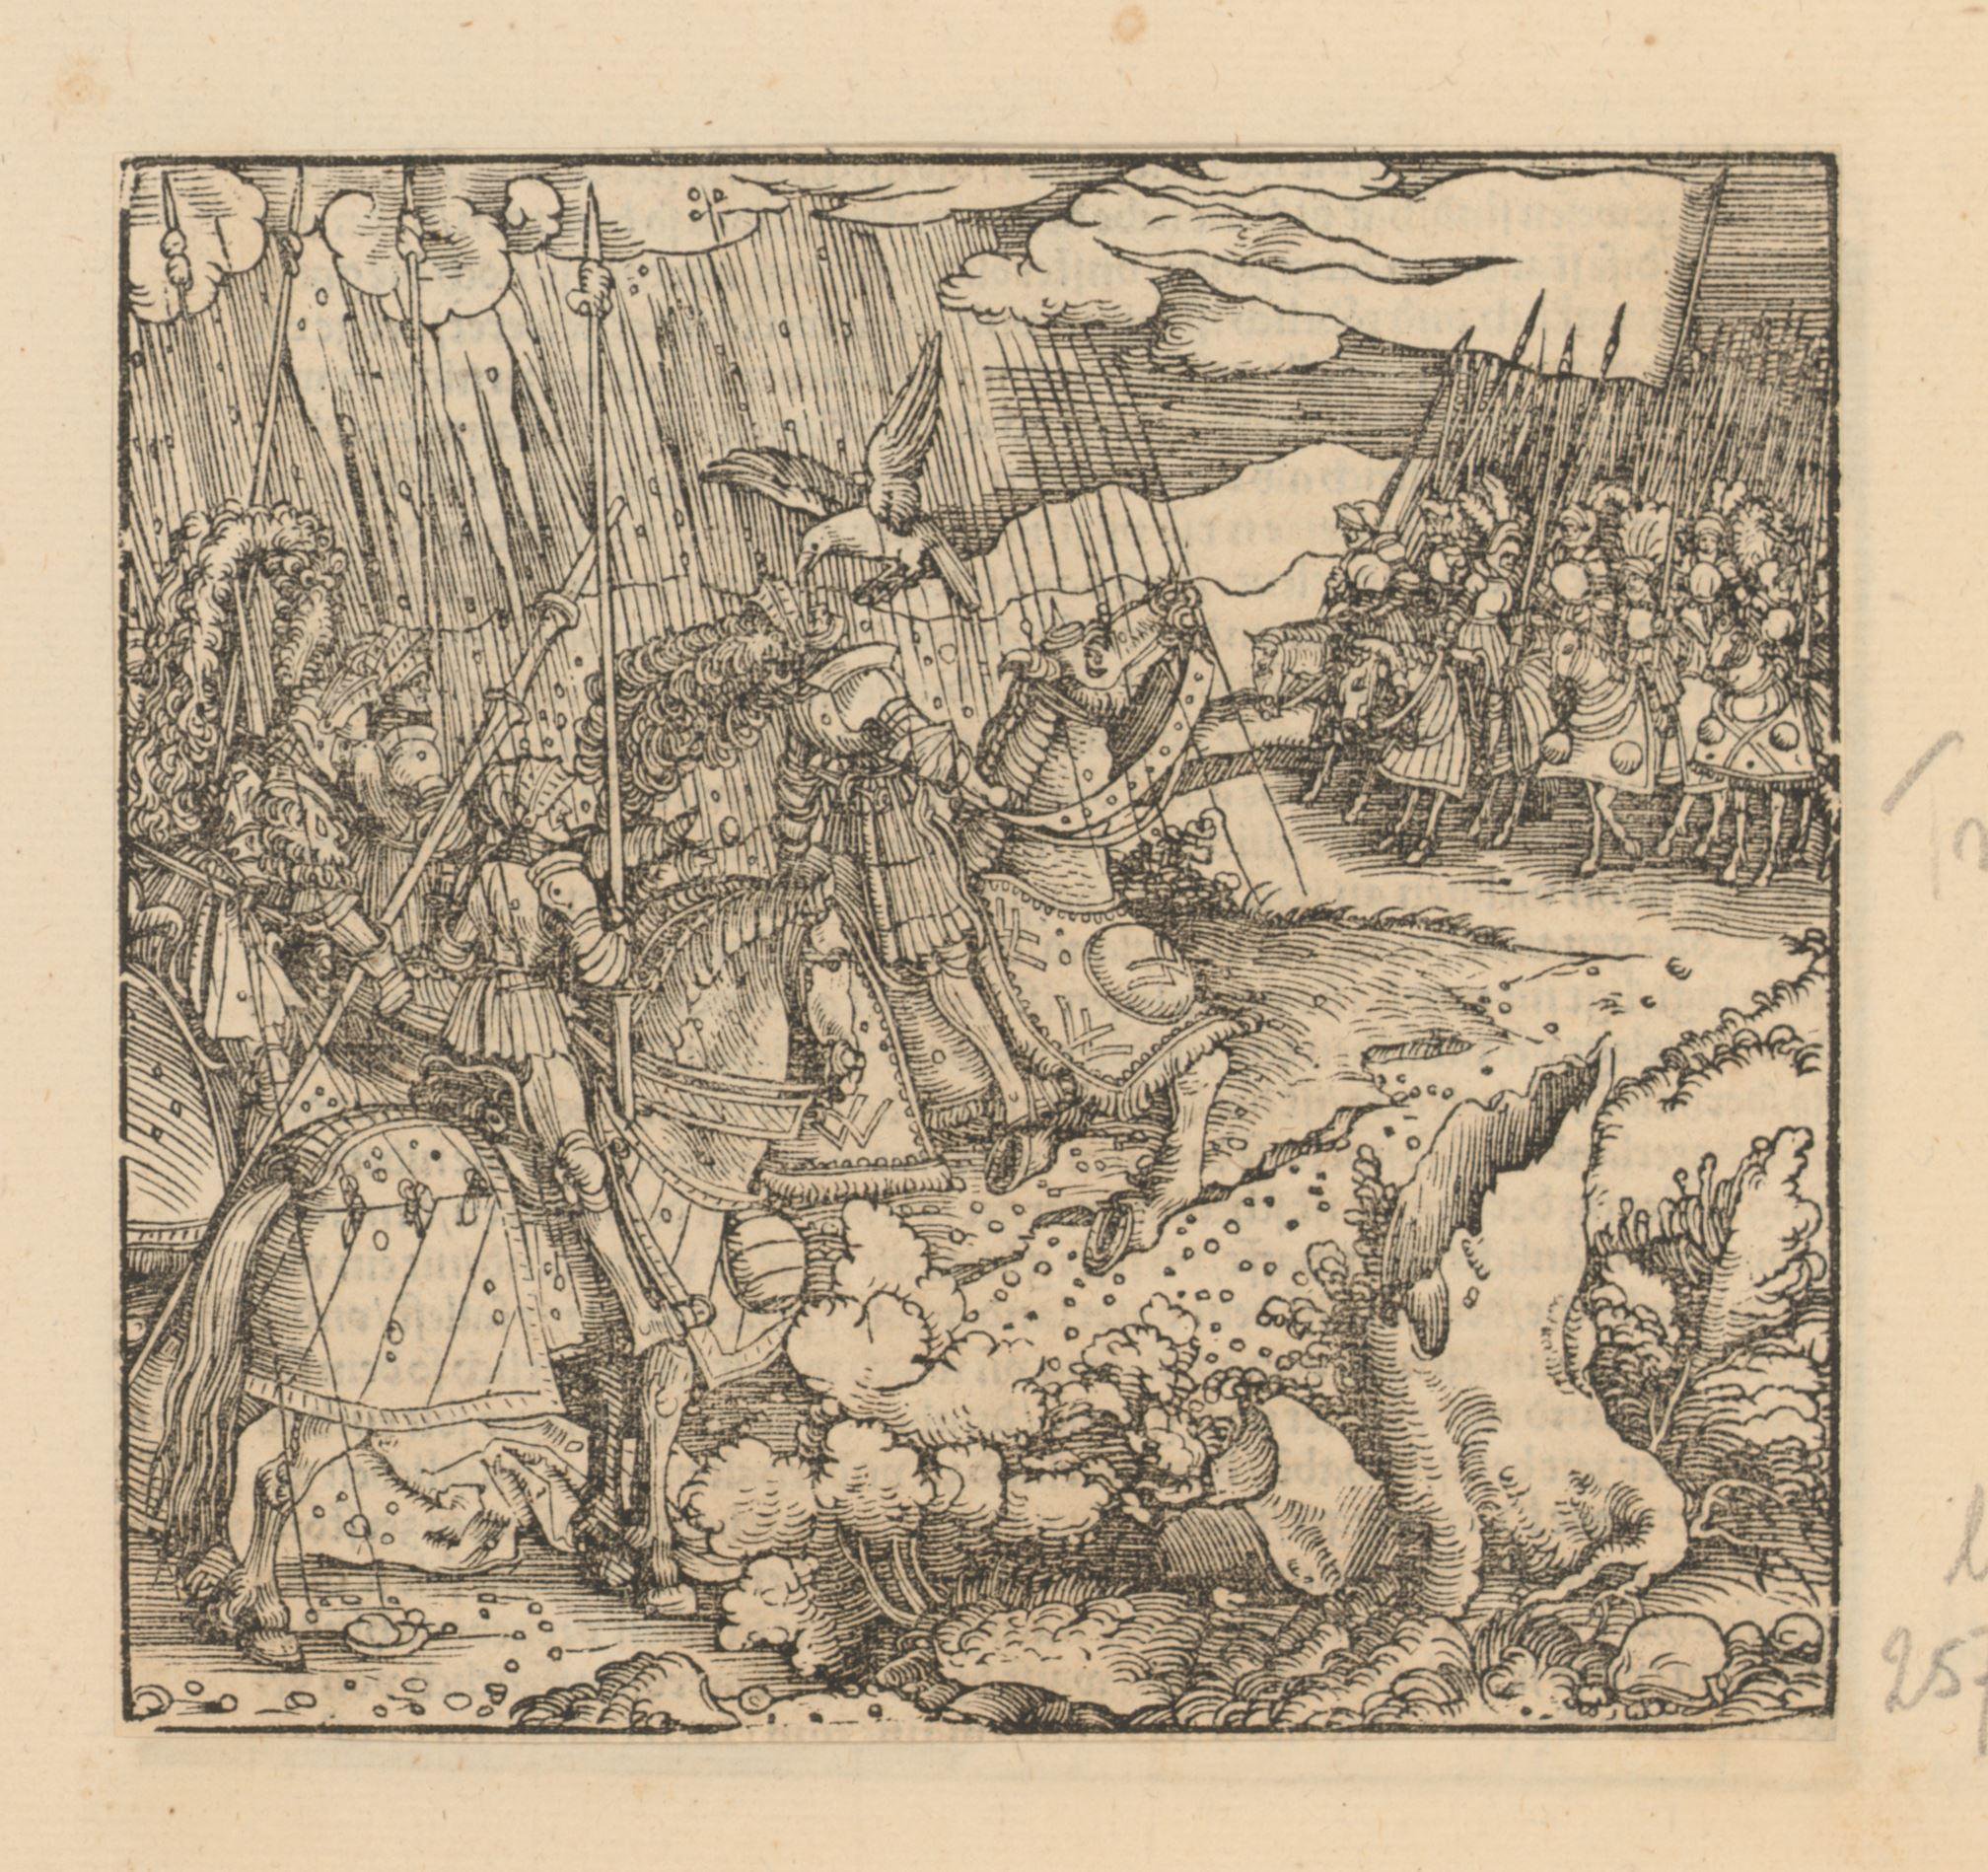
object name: print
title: Twee legers waarvan één wordt geteisterd door een hagelstorm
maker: Anonymous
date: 1514-1532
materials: paper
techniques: letterpress printing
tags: army 'en route', hail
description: Deze prent is gebruikt in: Petrarca, Francesco. Von der Artzney bayder Glück, des guten und widerwertigen: unnd weß sich ain yeder inn Gelück und Unglück halten sol (...). Augsburg: Heinrich Steiner, 1532. Deze uitgave is ook bekend onder de titel 'Trostspiegel in Glück und Unglück'.